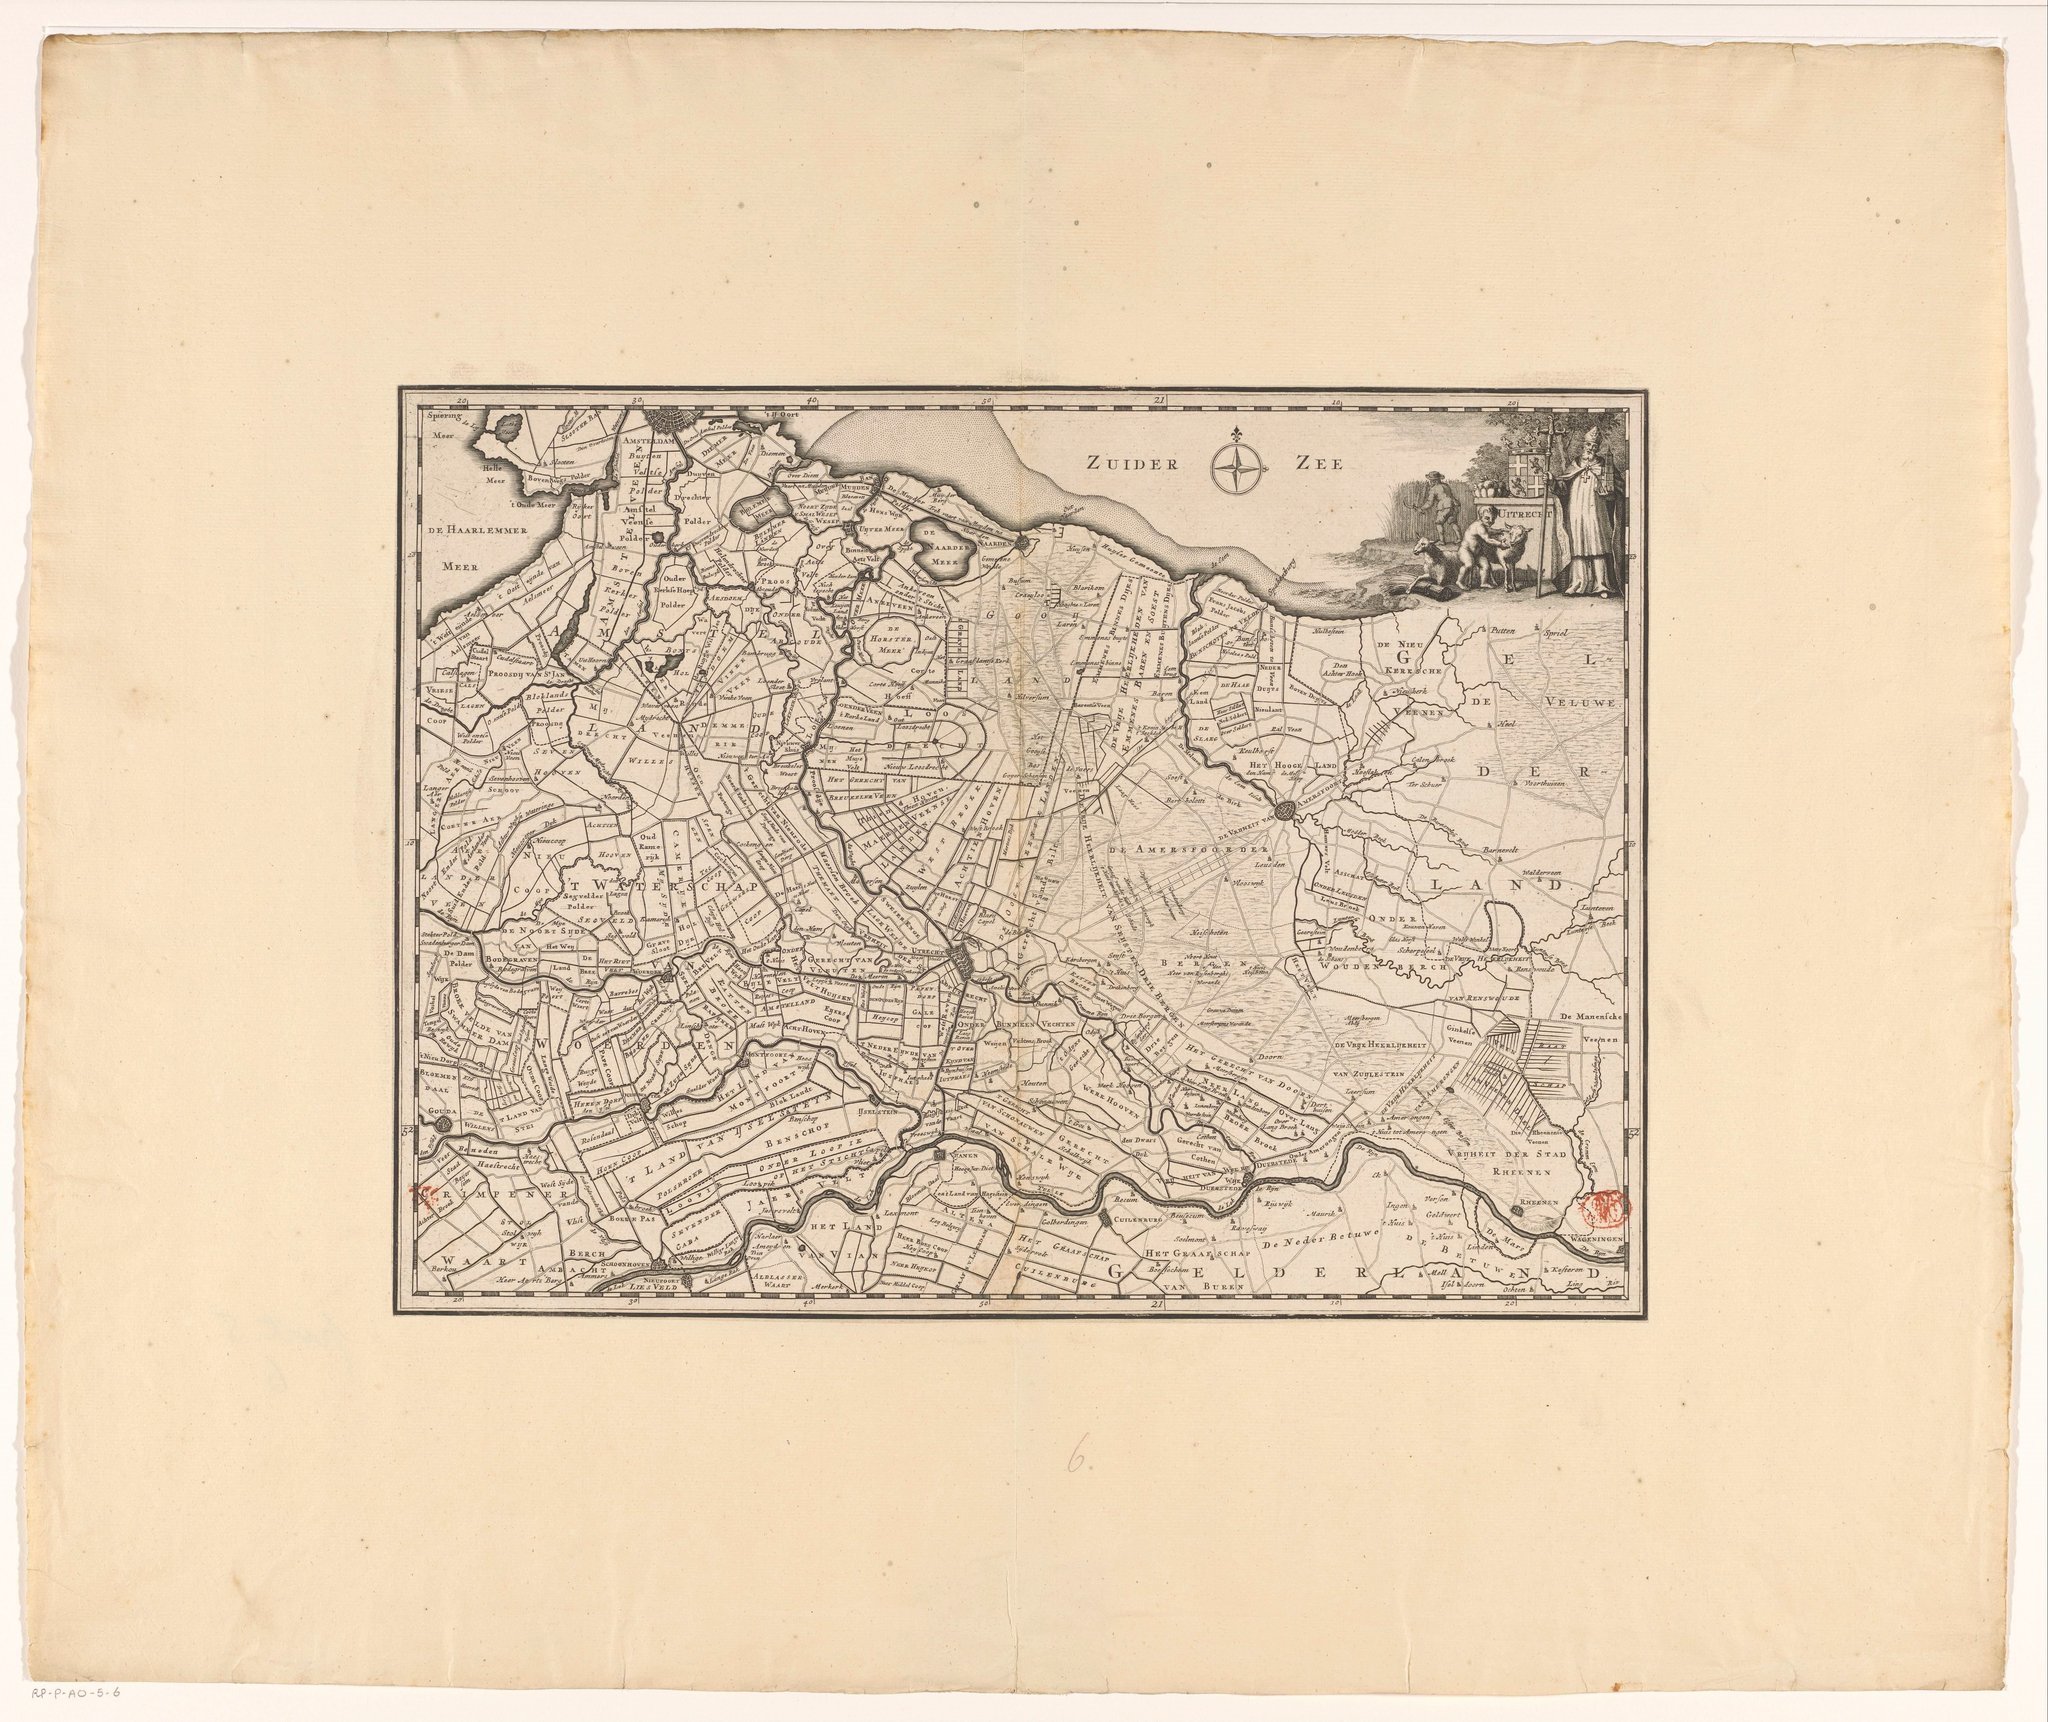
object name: print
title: Kaart van de provincie Utrecht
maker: Anonymous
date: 1725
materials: paper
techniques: engraving, etching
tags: coat of arms (as symbol of the state, etc.), maps of separate countries or regions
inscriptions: collector's mark: Lugt 195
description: Linksboven de titelcartouche met het wapen van de provincie Utrecht, een katholieke geestelijke met de Dom in zijn hand (waarschijnlijk een bisschop of domproost), een jongetje met twee schapen en op de achtergrond een landbouwer.